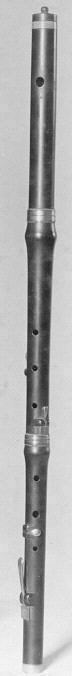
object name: transverse flute in b flat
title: Transverse Flute in B-flat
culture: british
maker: clementi & co.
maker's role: maker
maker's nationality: british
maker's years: 1798-1828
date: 1819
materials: ivory, silver, wood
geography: united kingdom